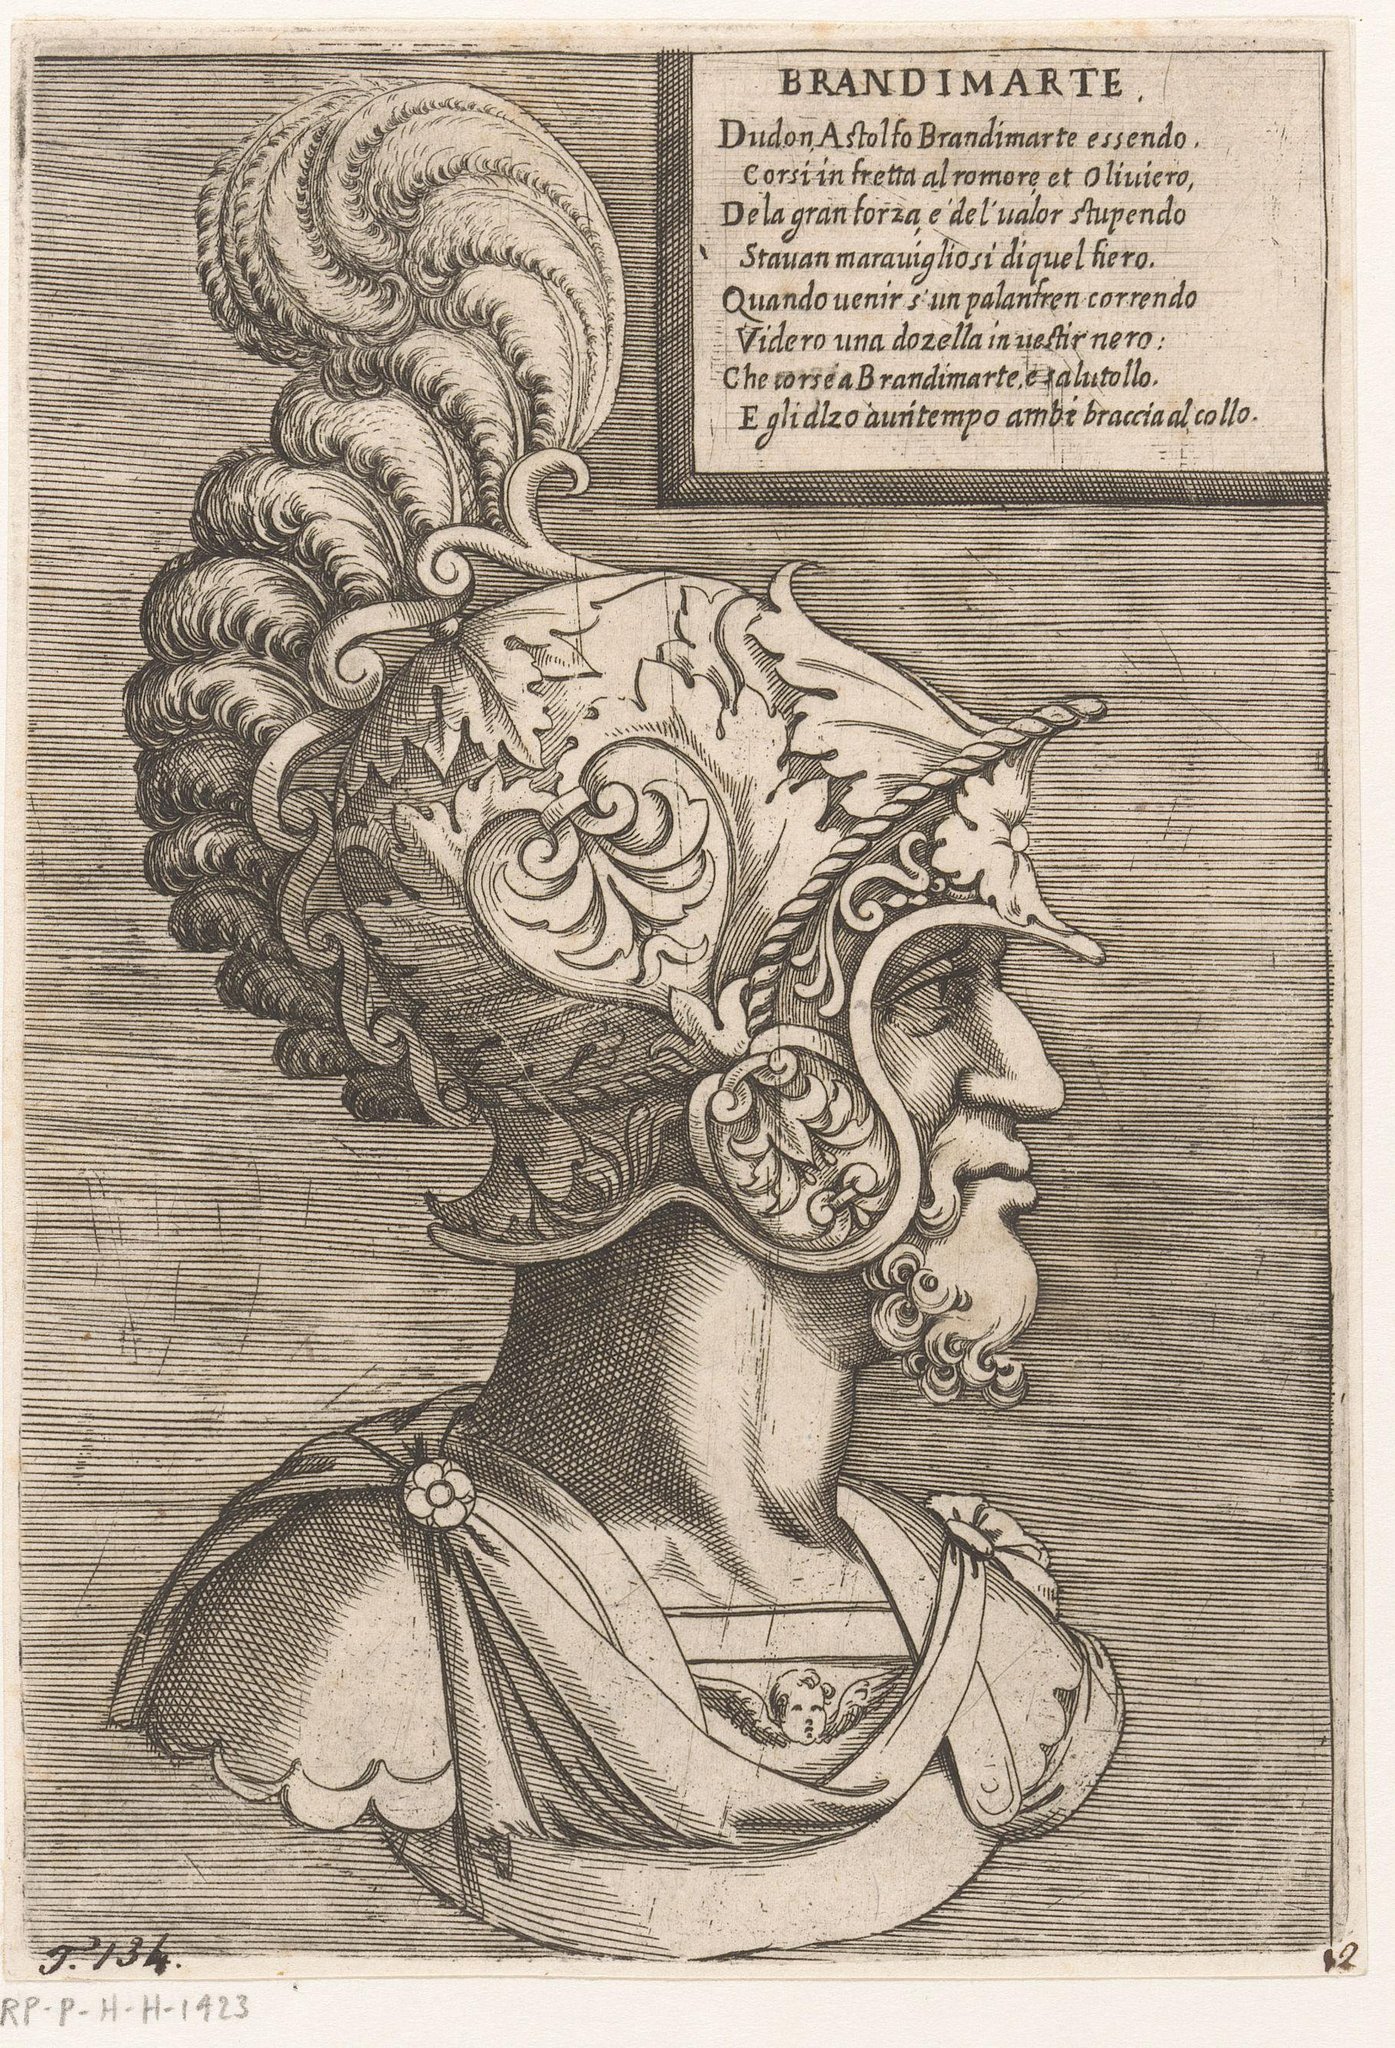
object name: print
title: Buste van Brandimarte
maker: Anonymous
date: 1550-1599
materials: paper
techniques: engraving, etching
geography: italy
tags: helmet, male characters from 'orlando furioso' : use 82a(...)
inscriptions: collector's mark: Lugt 2228, collector's mark: Lugt 11, number: ‘12’, inscription: ‘T. 134’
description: Buste van Brandimarte, een karakter uit Ludovico Ariosto's epos 'Orlando Furioso'. Op zijn hoofd draagt hij een helm gedecoreerd met bladeren en pluimen van veren. Rechtsboven de titel en acht Italiaanse versregels uit het epos.